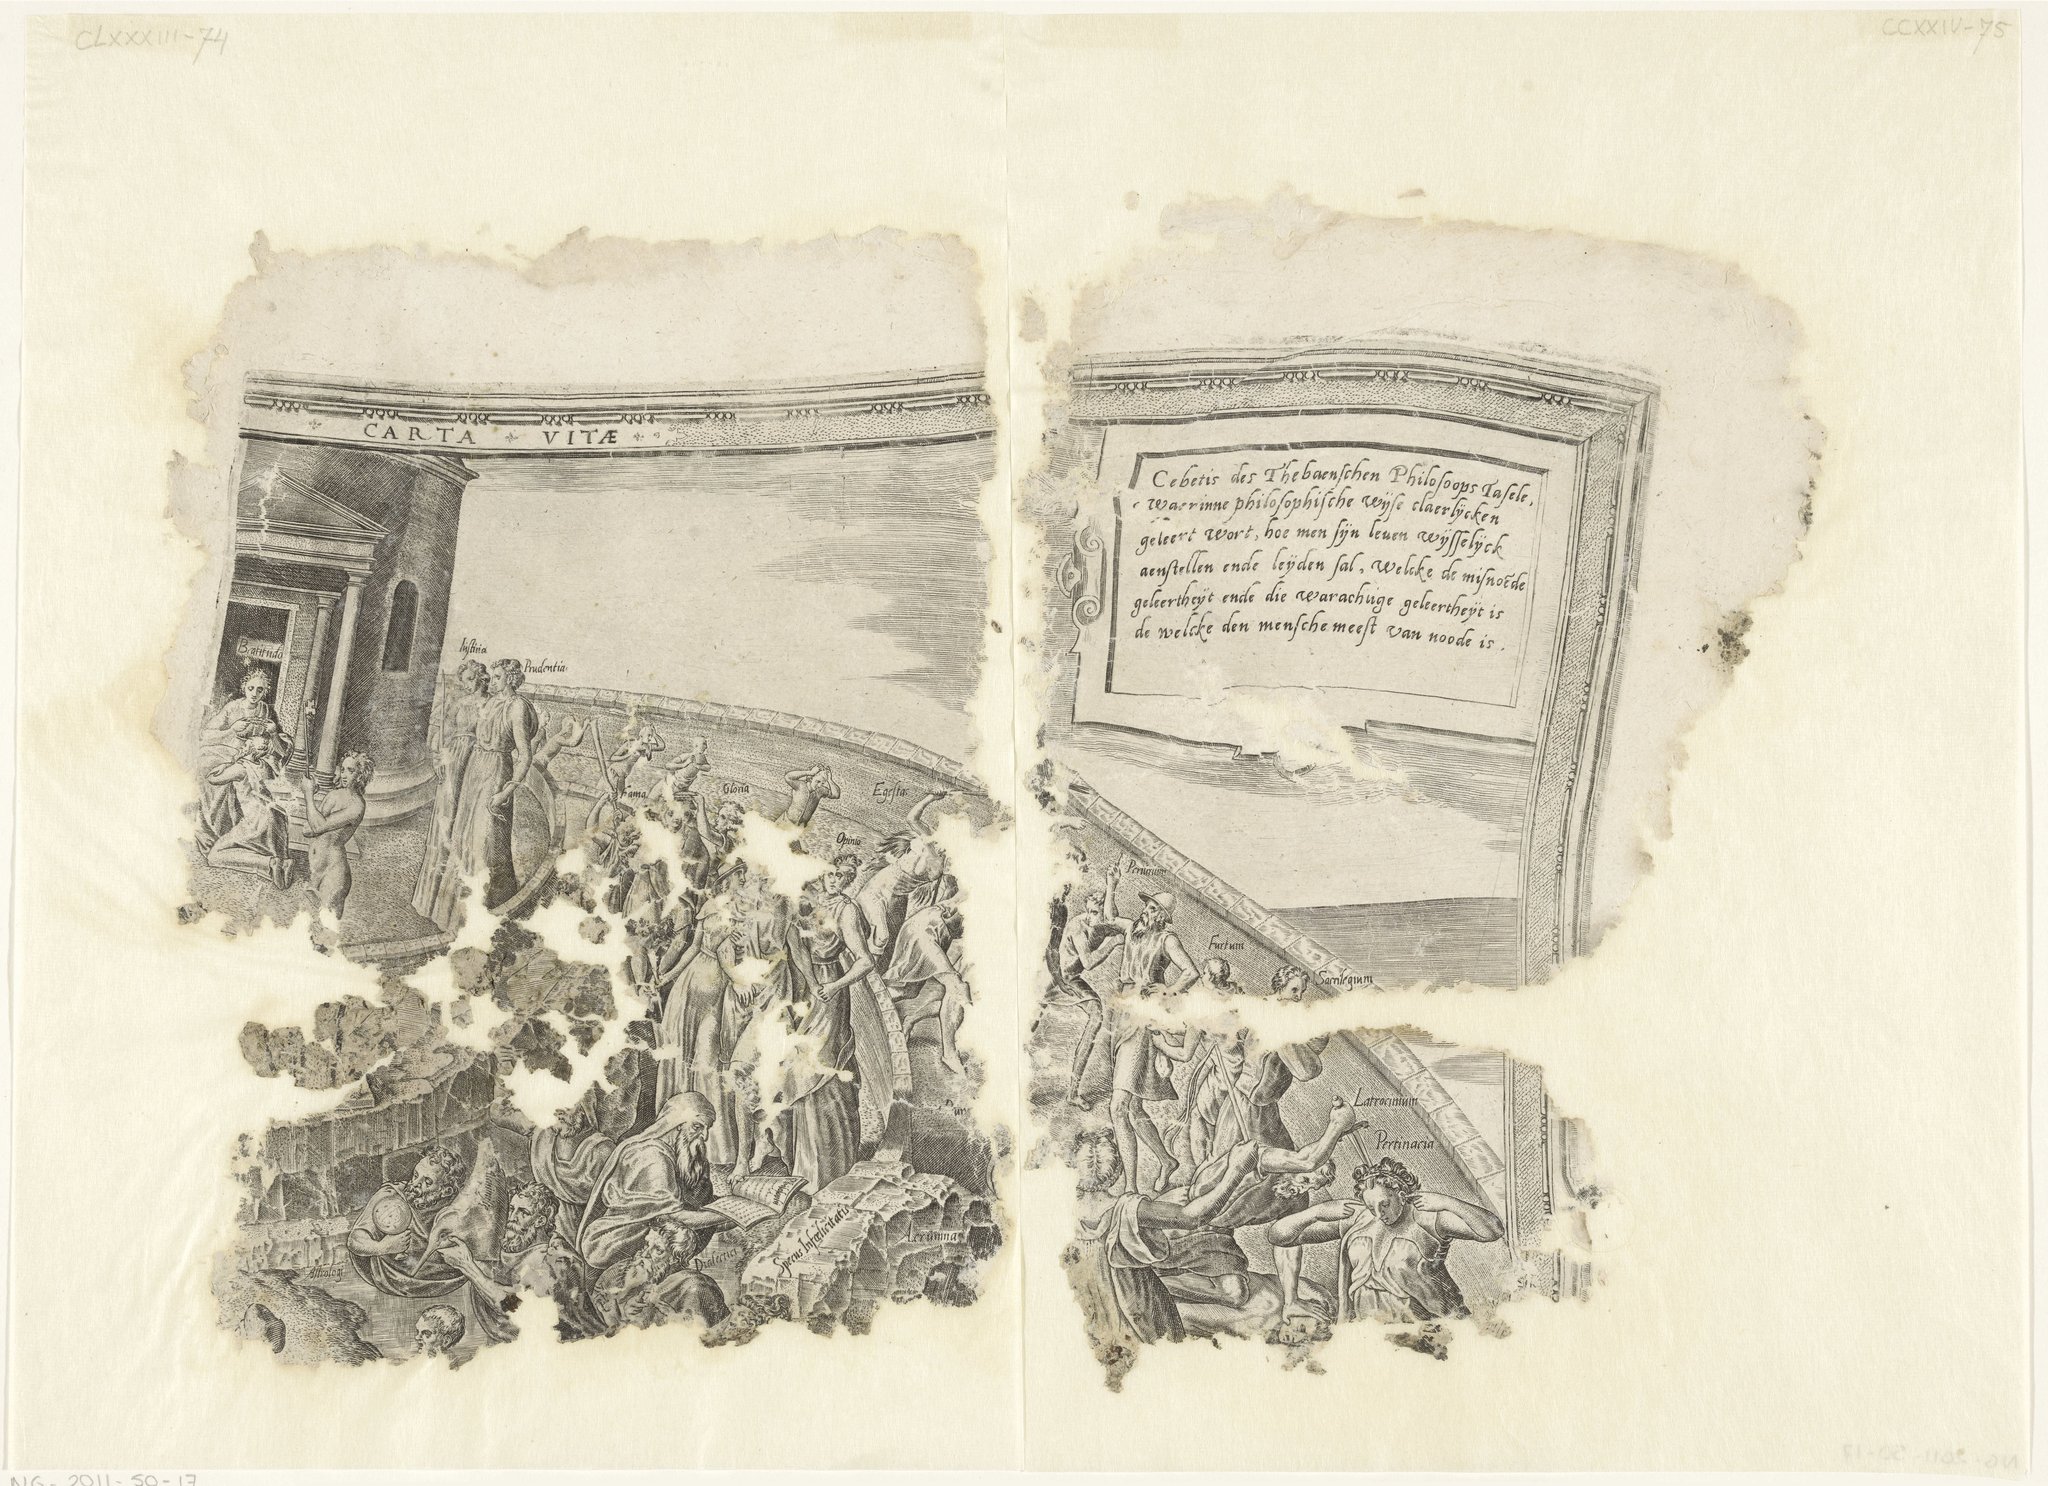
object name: print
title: Rechterbovenhoek van een prent van het tafereel van Cebes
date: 1561-1596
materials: paper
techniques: engraving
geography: southern netherlands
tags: 'tabula cebetis'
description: Allegorie over de heilsweg van de mens. Het leven als een stad met drie ommuurde terreinen, met in het midden een tempel. Bij de buitenste poort staan de zielen van kinderen te wachten, klaar om het volwassen leven te betreden. Voor het binnengaan krijgen zij iets te drinken van Verleiding (Seductio), die hen onwetend maakt. Het eerste ommuurde terrein toont allerlei ver- en afleidingen, zoals Vooroordeel (Opinio), Begeerte (Cupiduas), Twijfel (Error) en Onwetendheid (Ignorantia). Zij beletten de jeugdige mens verder door te dringen tot de volgende cirkel. Alleen door de personificaties te volgen van Berouw (Poenitentia), Hoop (Spes) en Goed Verlangen (Bonnem Desiderium) kan de mens toegang krijgen tot de tweede cirkel. Daar krijgt hij onderricht in alle vormen van wereldse kennis. Links staan de zeven artes liberales en rechts debatteren verschillende geleerden. De mens wordt in deze cirkel op de proef gesteld en geconfronteerd met valse kennis (Falsa Disciplina). Met behulp van Zelfbeheersing (Continentia) en Geduldigheid (Tolerantia) kan de berg verder worden beklommen. Het derde ommuurde terrein, ten slotte, wordt bewaakt door Waarheid (Veritas). Zij verleent de mens toegang tot het ware geluk. Hij wordt er verwelkomd door de kardinale deugden en mag verblijven in het huis van de gelukzaligen, waar het ware geluk op hem wacht. Gereconstrueerd uit twee fragmenten.